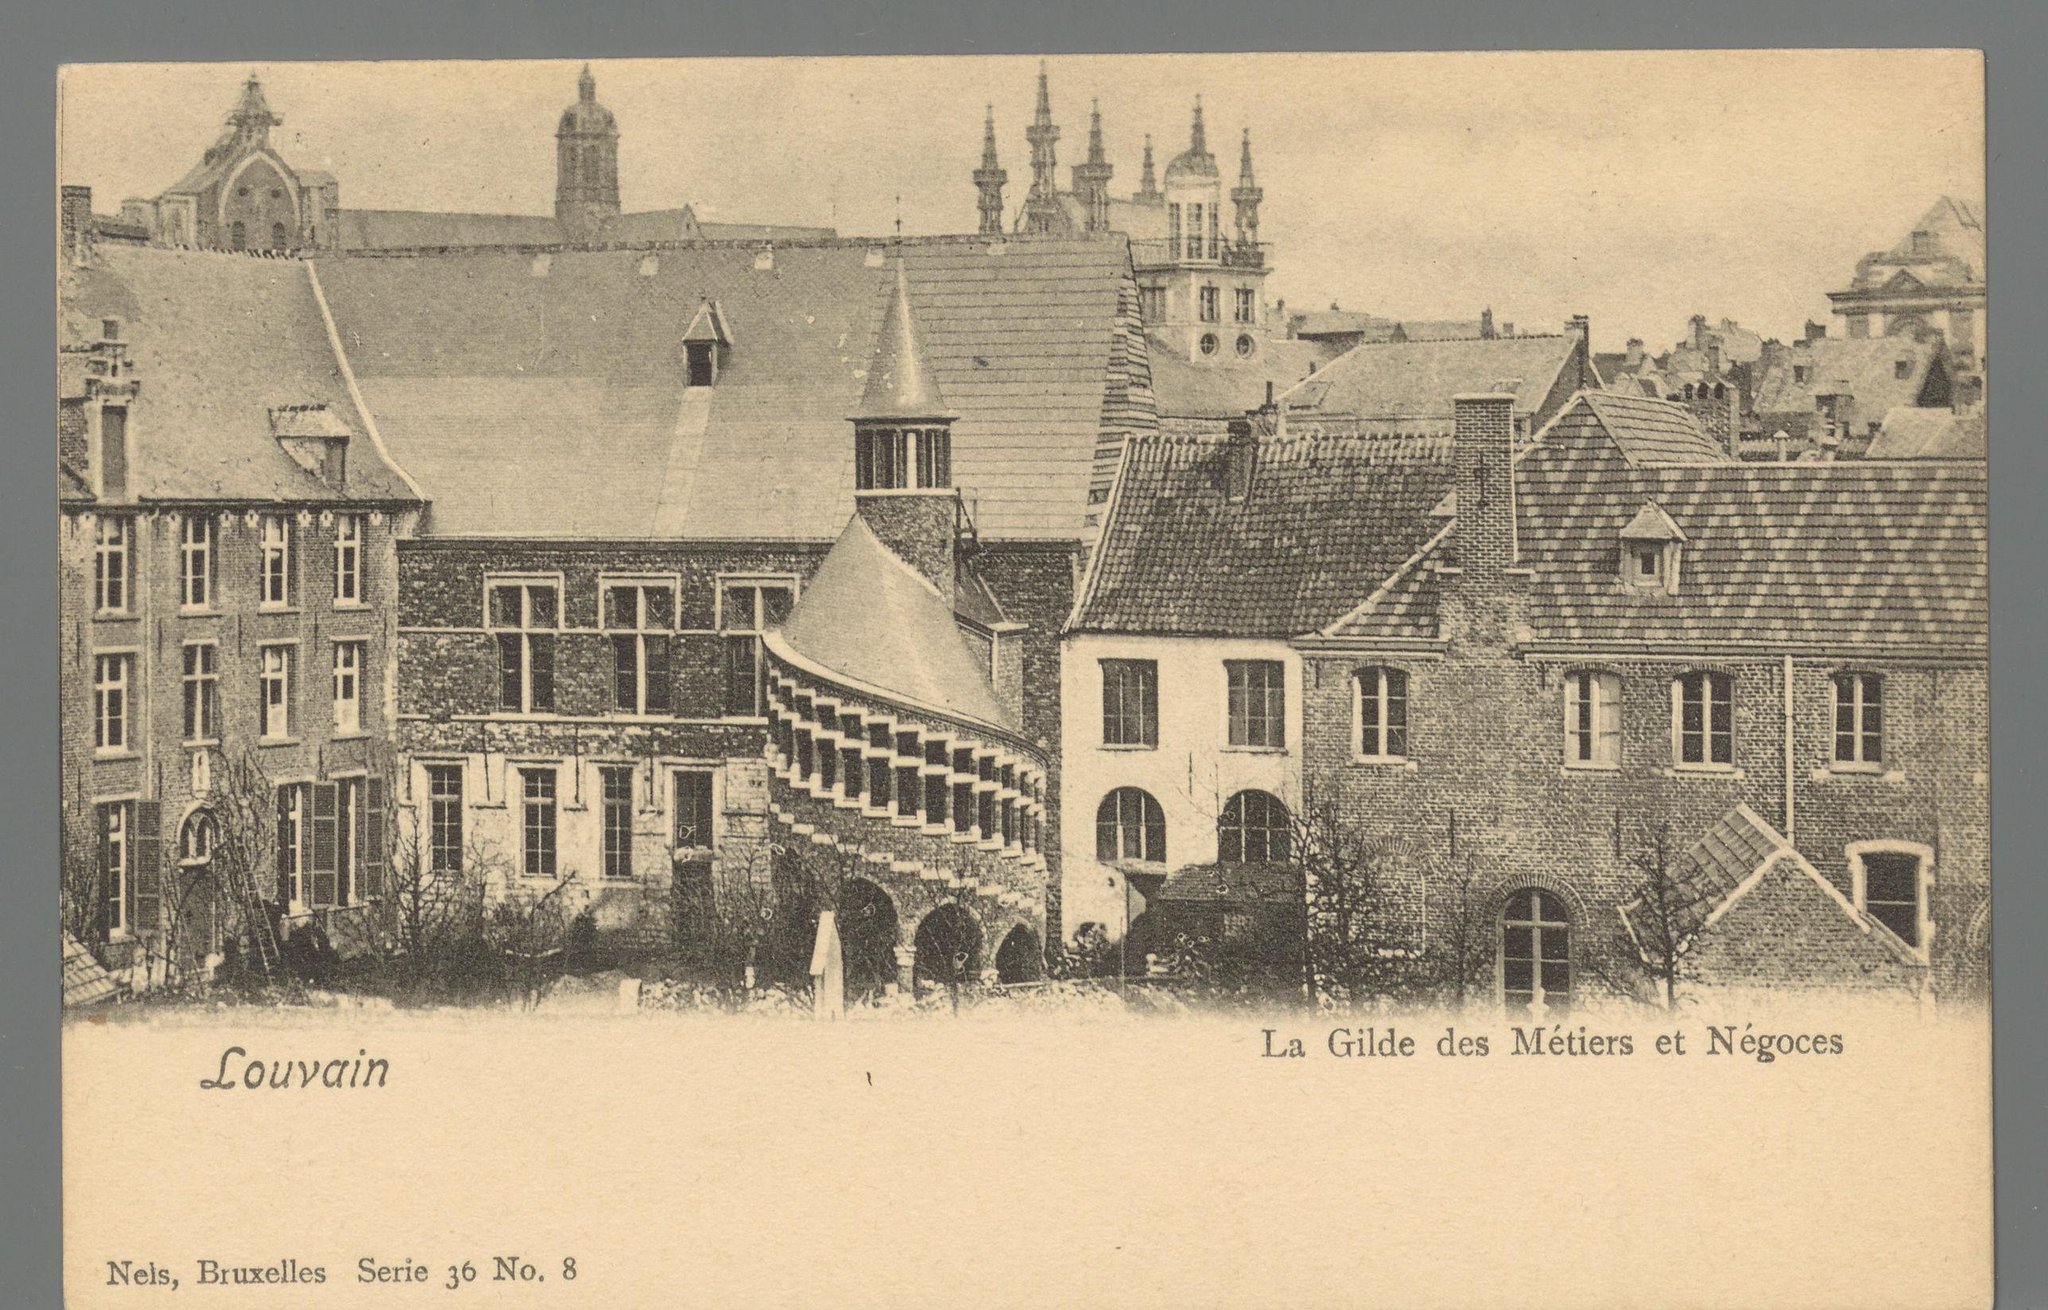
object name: ansichtkaart, prentbriefkaart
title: Série 36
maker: Anonymous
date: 1898-1906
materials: cardboard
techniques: photograph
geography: leuven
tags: urban housing, city-view, and landscape with man-made constructions, louvain